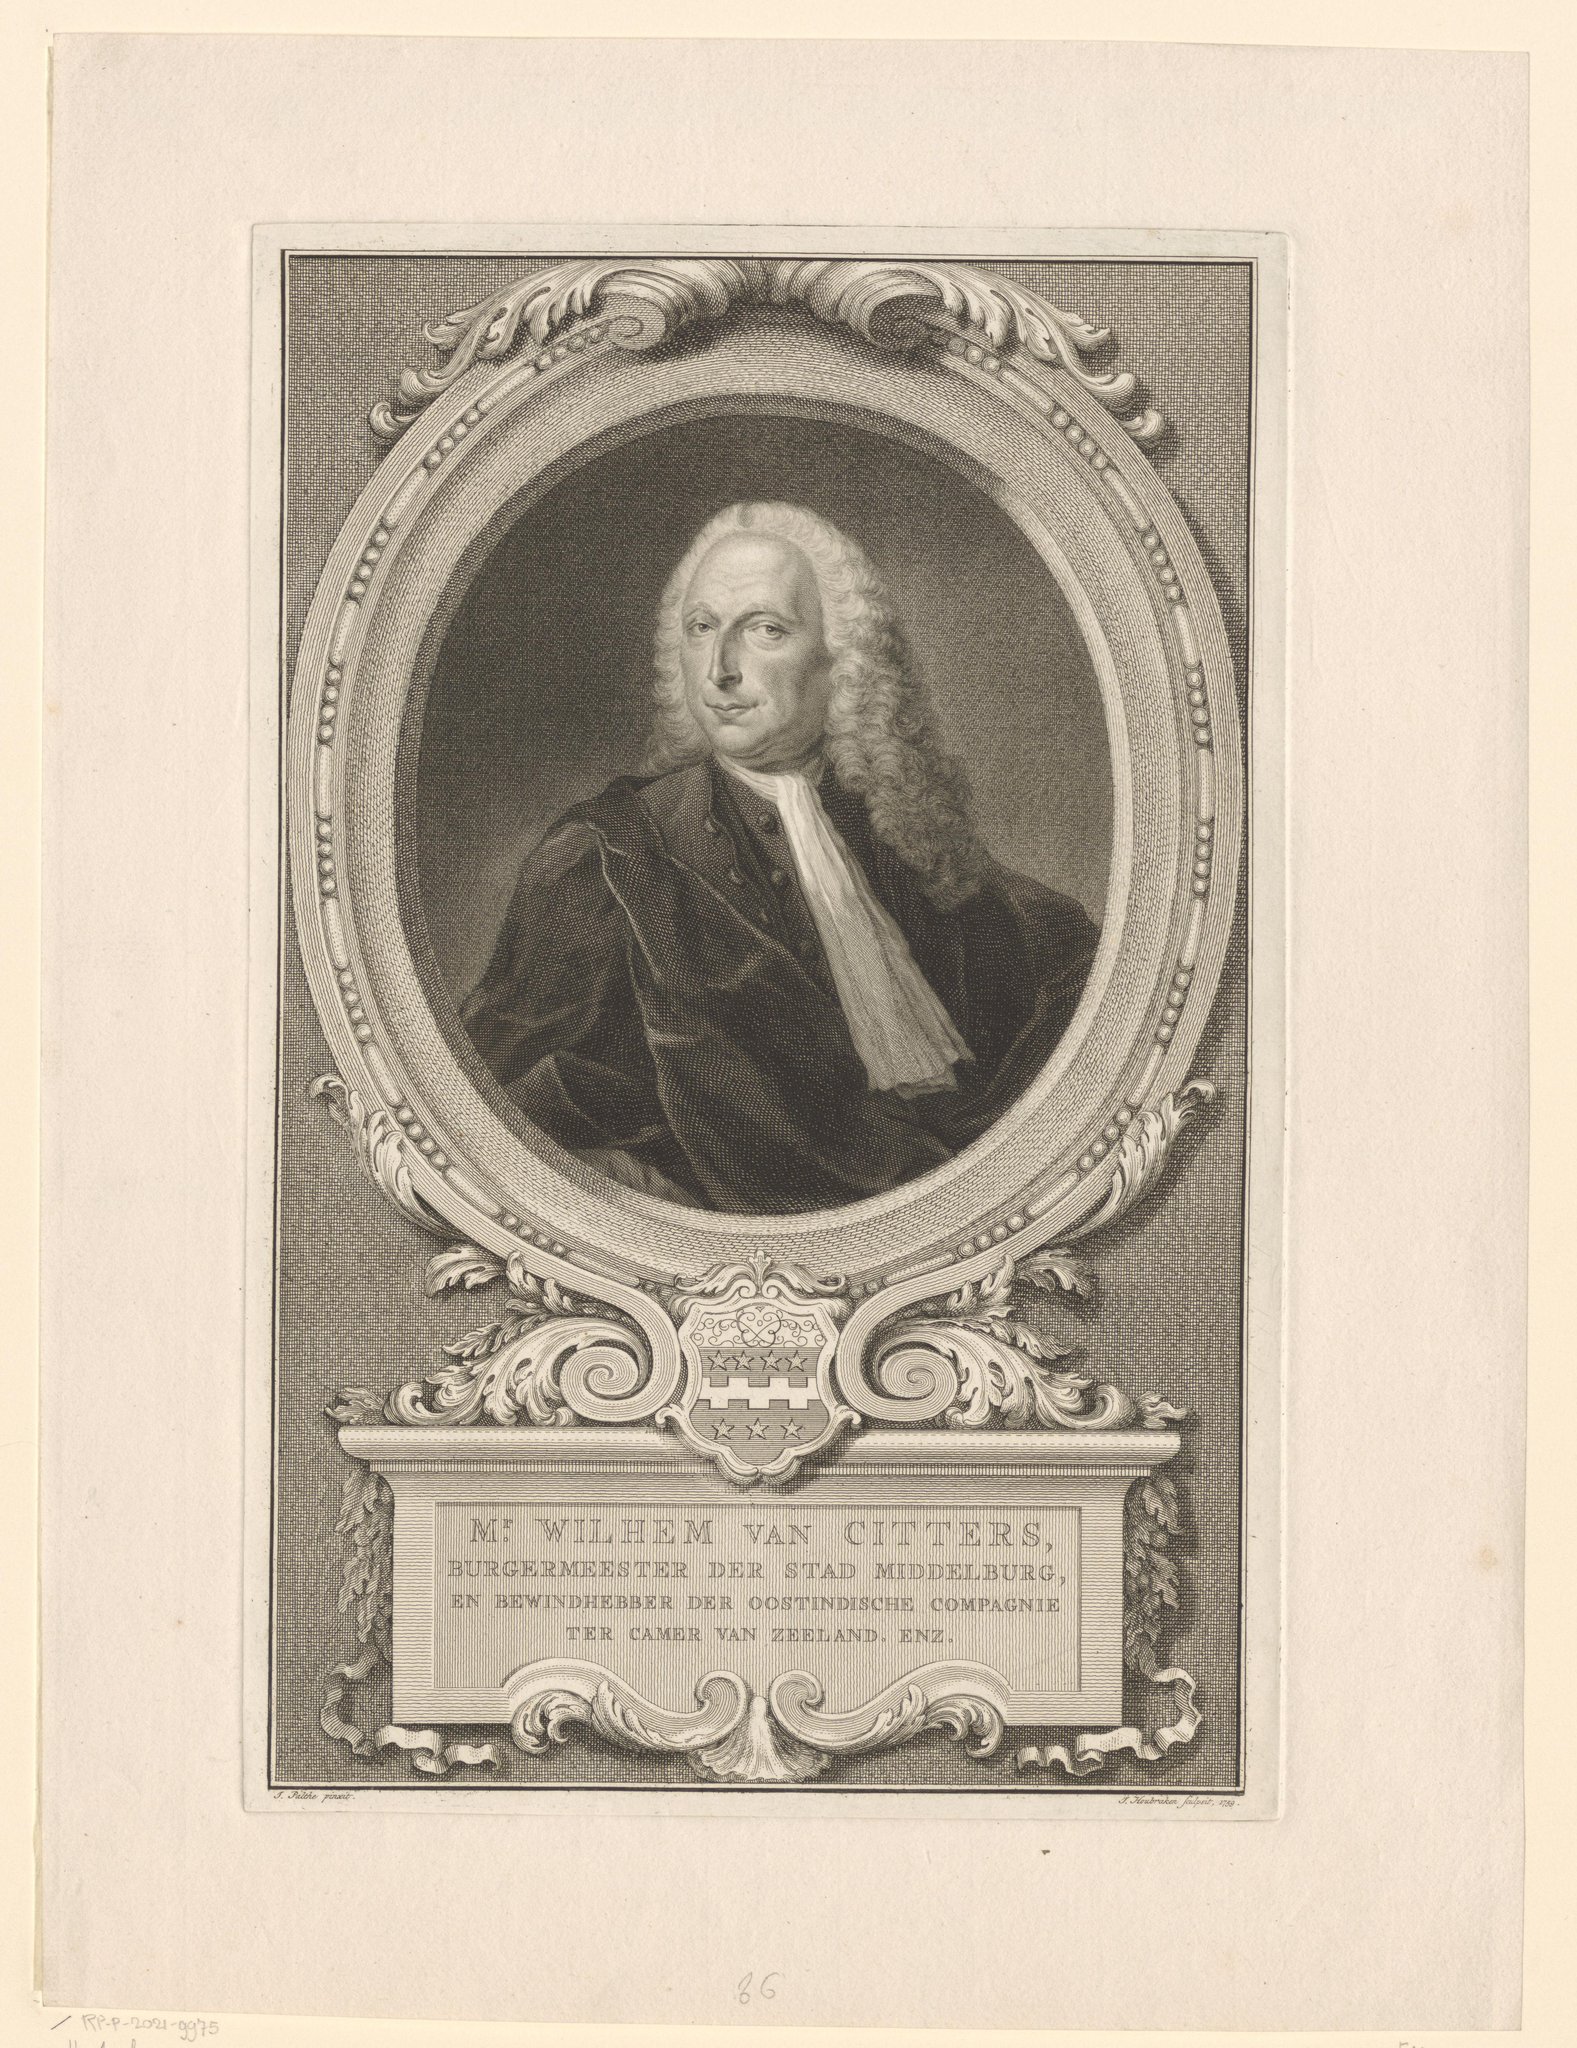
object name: print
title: Portret van Willem van Citters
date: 1759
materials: paper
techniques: engraving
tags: london, mayor, historical persons, armorial bearing, heraldry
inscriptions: date